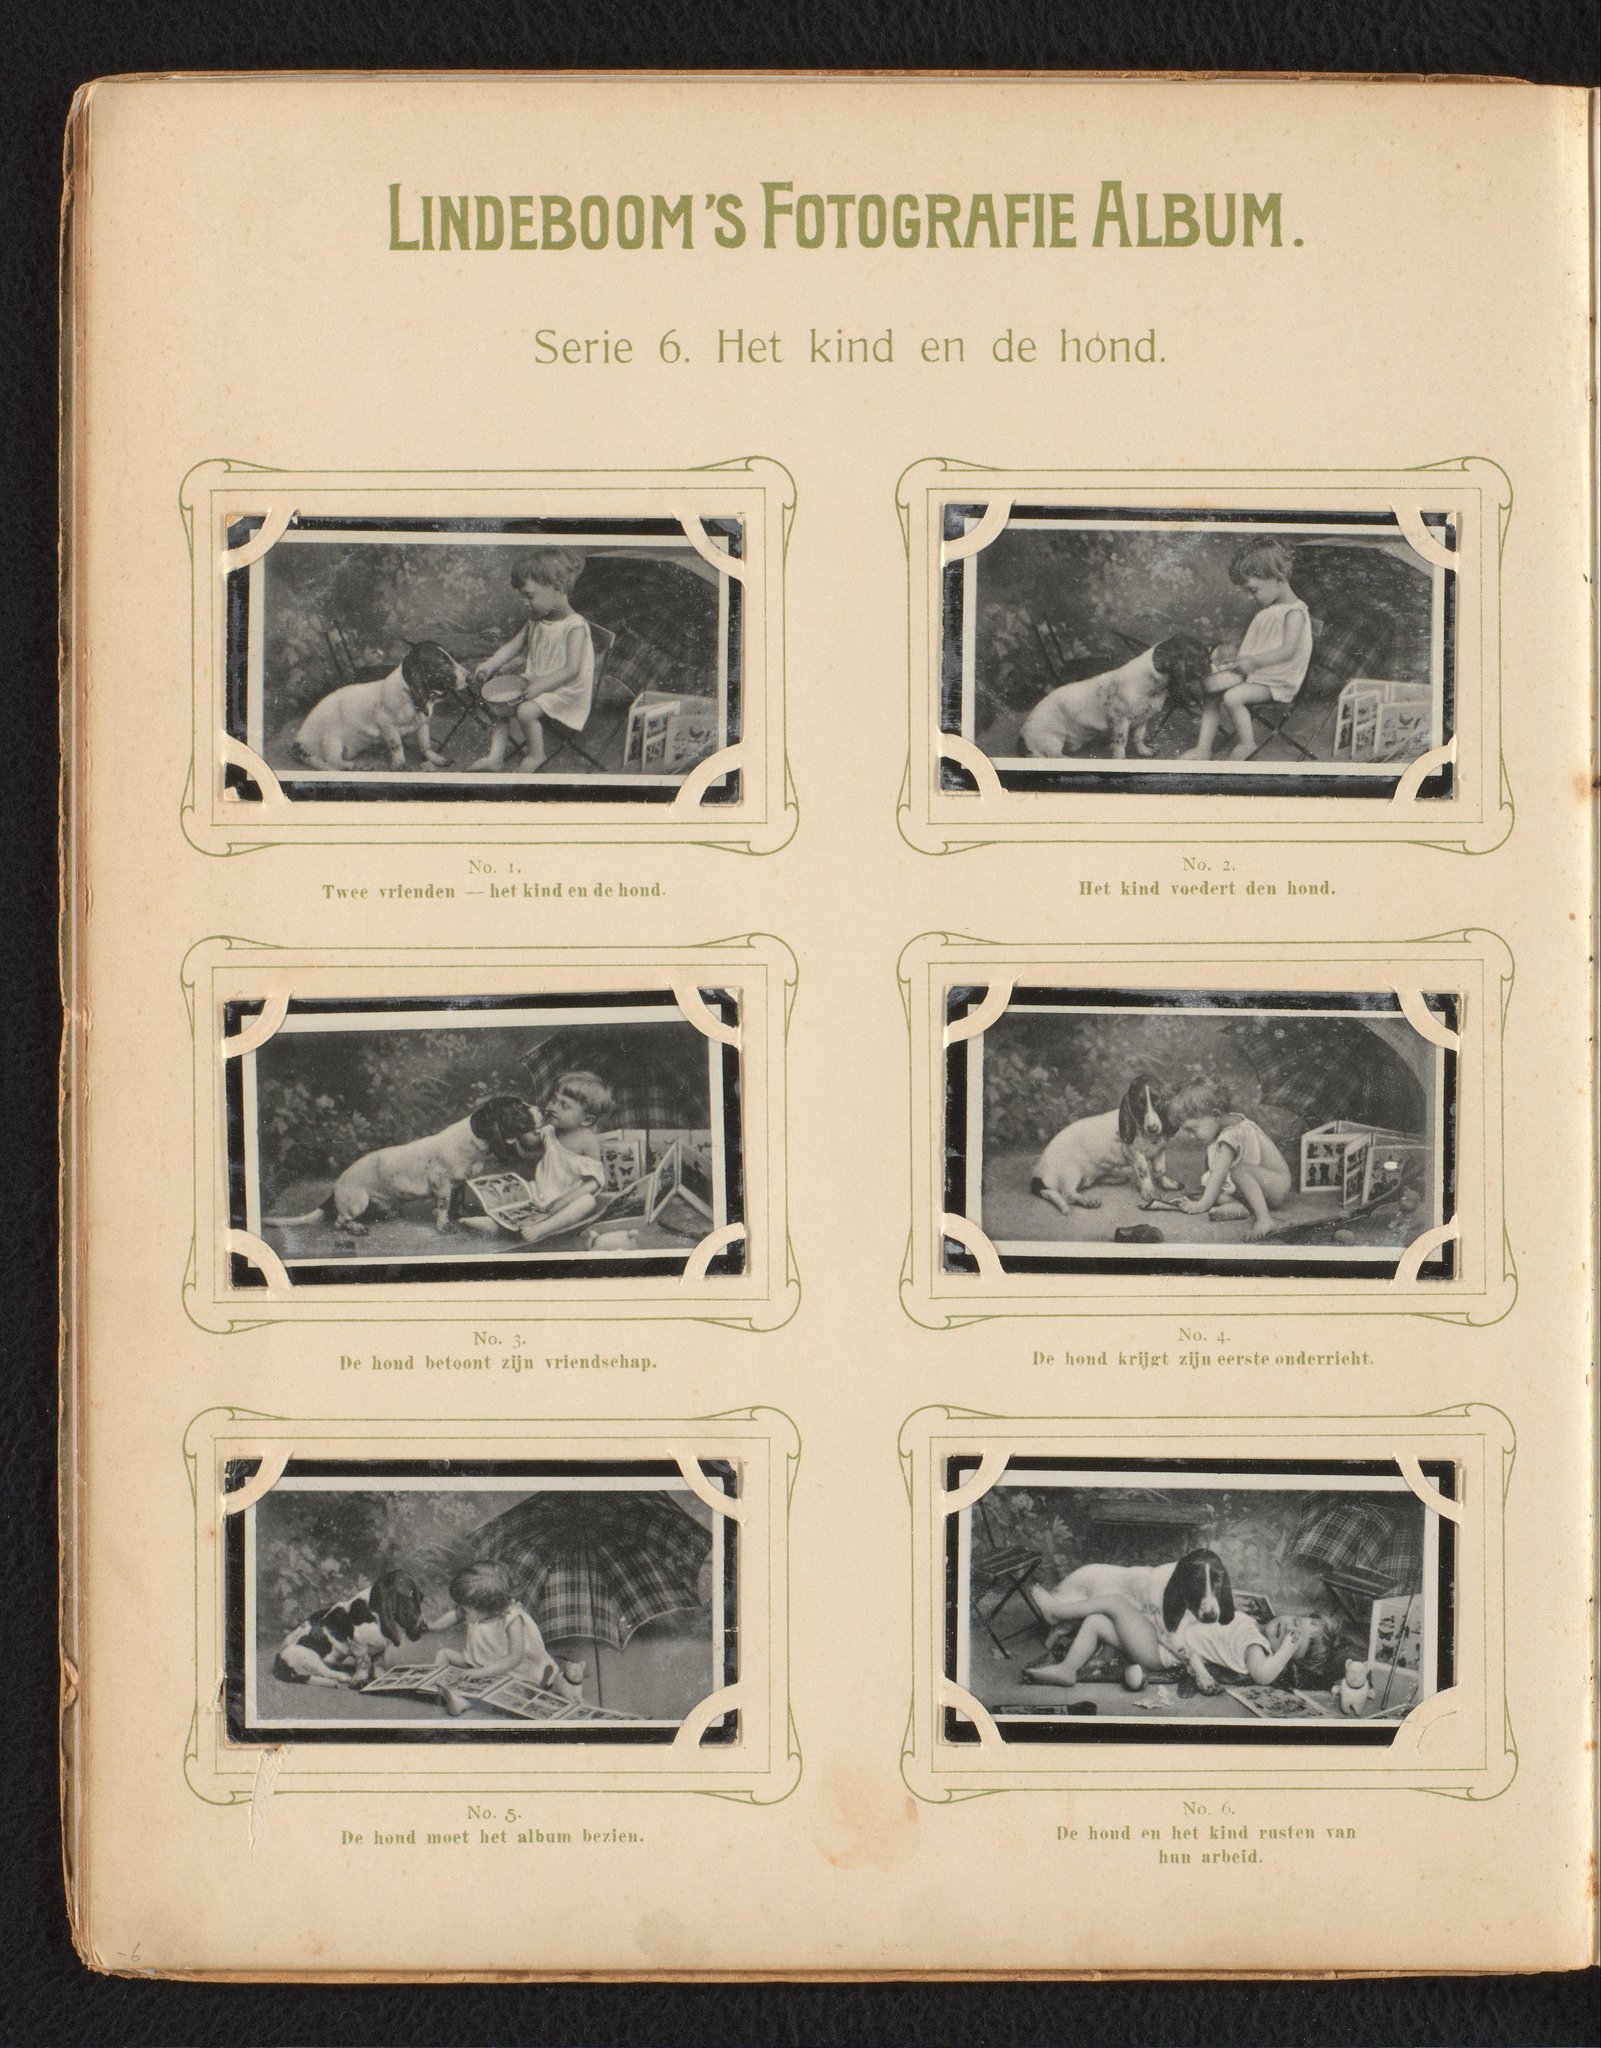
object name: reproduction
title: Het kind en de hond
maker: Anonymous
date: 1905-1906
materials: cardboard, paper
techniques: photograph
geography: amsterdam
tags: child, dog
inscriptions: inscription: ‘Serie 6.’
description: Dergelijke prenten stonden bekend als 'zwartjes'. Men verkreeg ze bij aanschaf van bepaalde merken thee, cacao, sigaretten, beschuit, etc. om te verzamelen. Er waren speciaal voor de 'zwartjes' vervaardigde verzamelalbums in omloop.